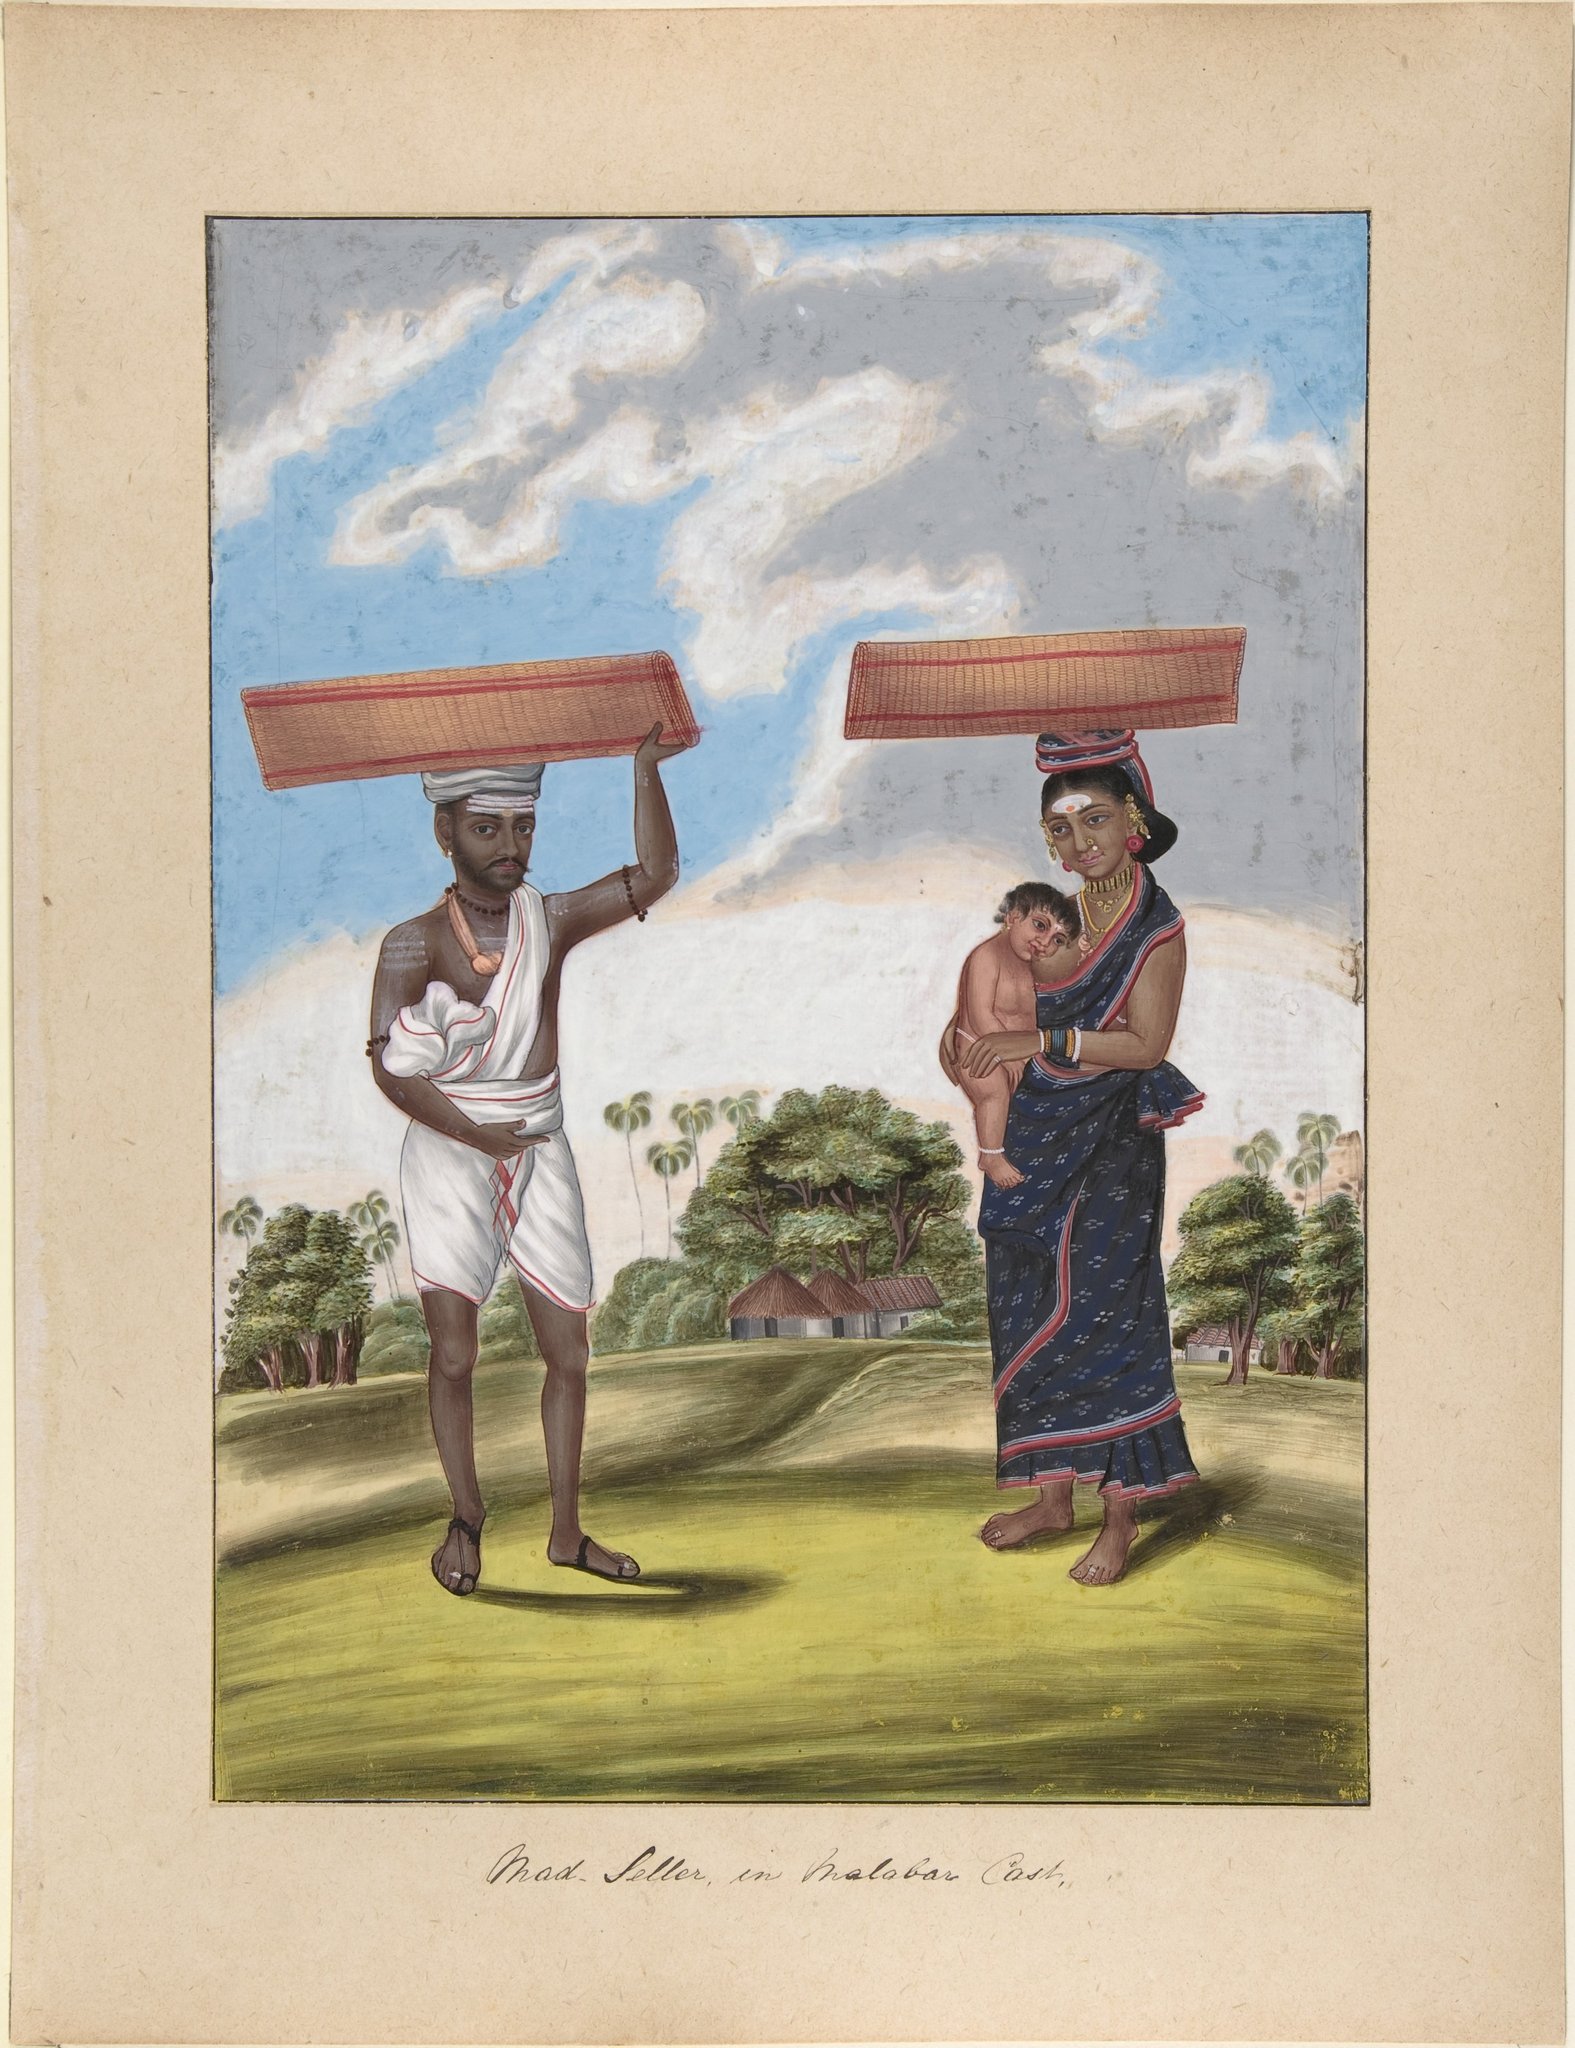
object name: drawing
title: Mad-seller, in Malabar Cast, from Indian Trades and Castes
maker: anonymous, indian, 19th century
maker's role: artist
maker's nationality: indian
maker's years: 1800-1900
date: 1840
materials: gouache, watercolor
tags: infants,men,women